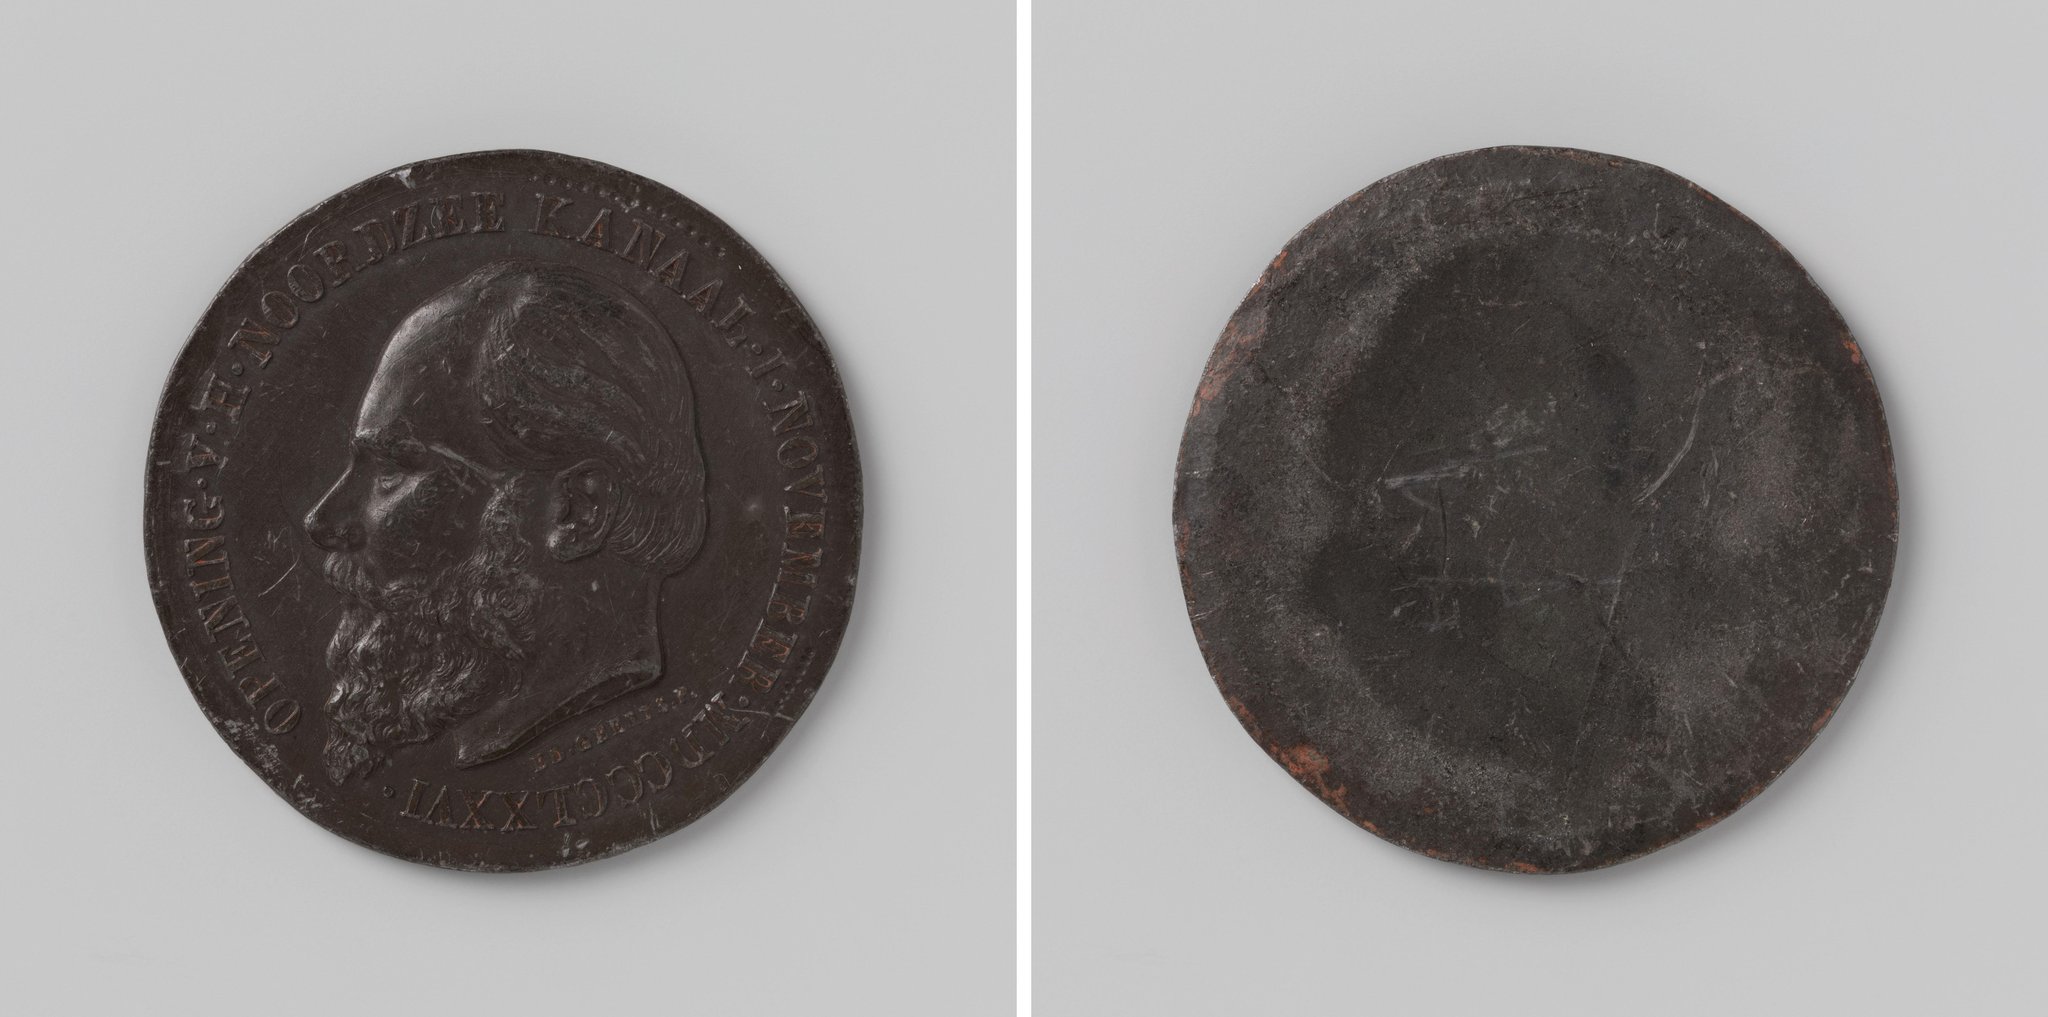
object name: history medal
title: Opening van het Noordzeekanaal, ter ere van Willem III, koning der Nederlanden, penning geslagen op last van de Amsterdamsche Kanaal Maatschappij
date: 1876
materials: lead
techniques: striking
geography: brussels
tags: brussels, willem iii (koning der nederlanden)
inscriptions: signature: ‘ED. GEERTS’, inscription: ‘OPENING . V.H. NOORDZEEKANAAL . I . NOVEMBER . MDCCCLXXVI’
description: Eenzijdige loden penning. Voorzijde: borststuk Willem III binnen omschrift. Keerzijde: blanco.